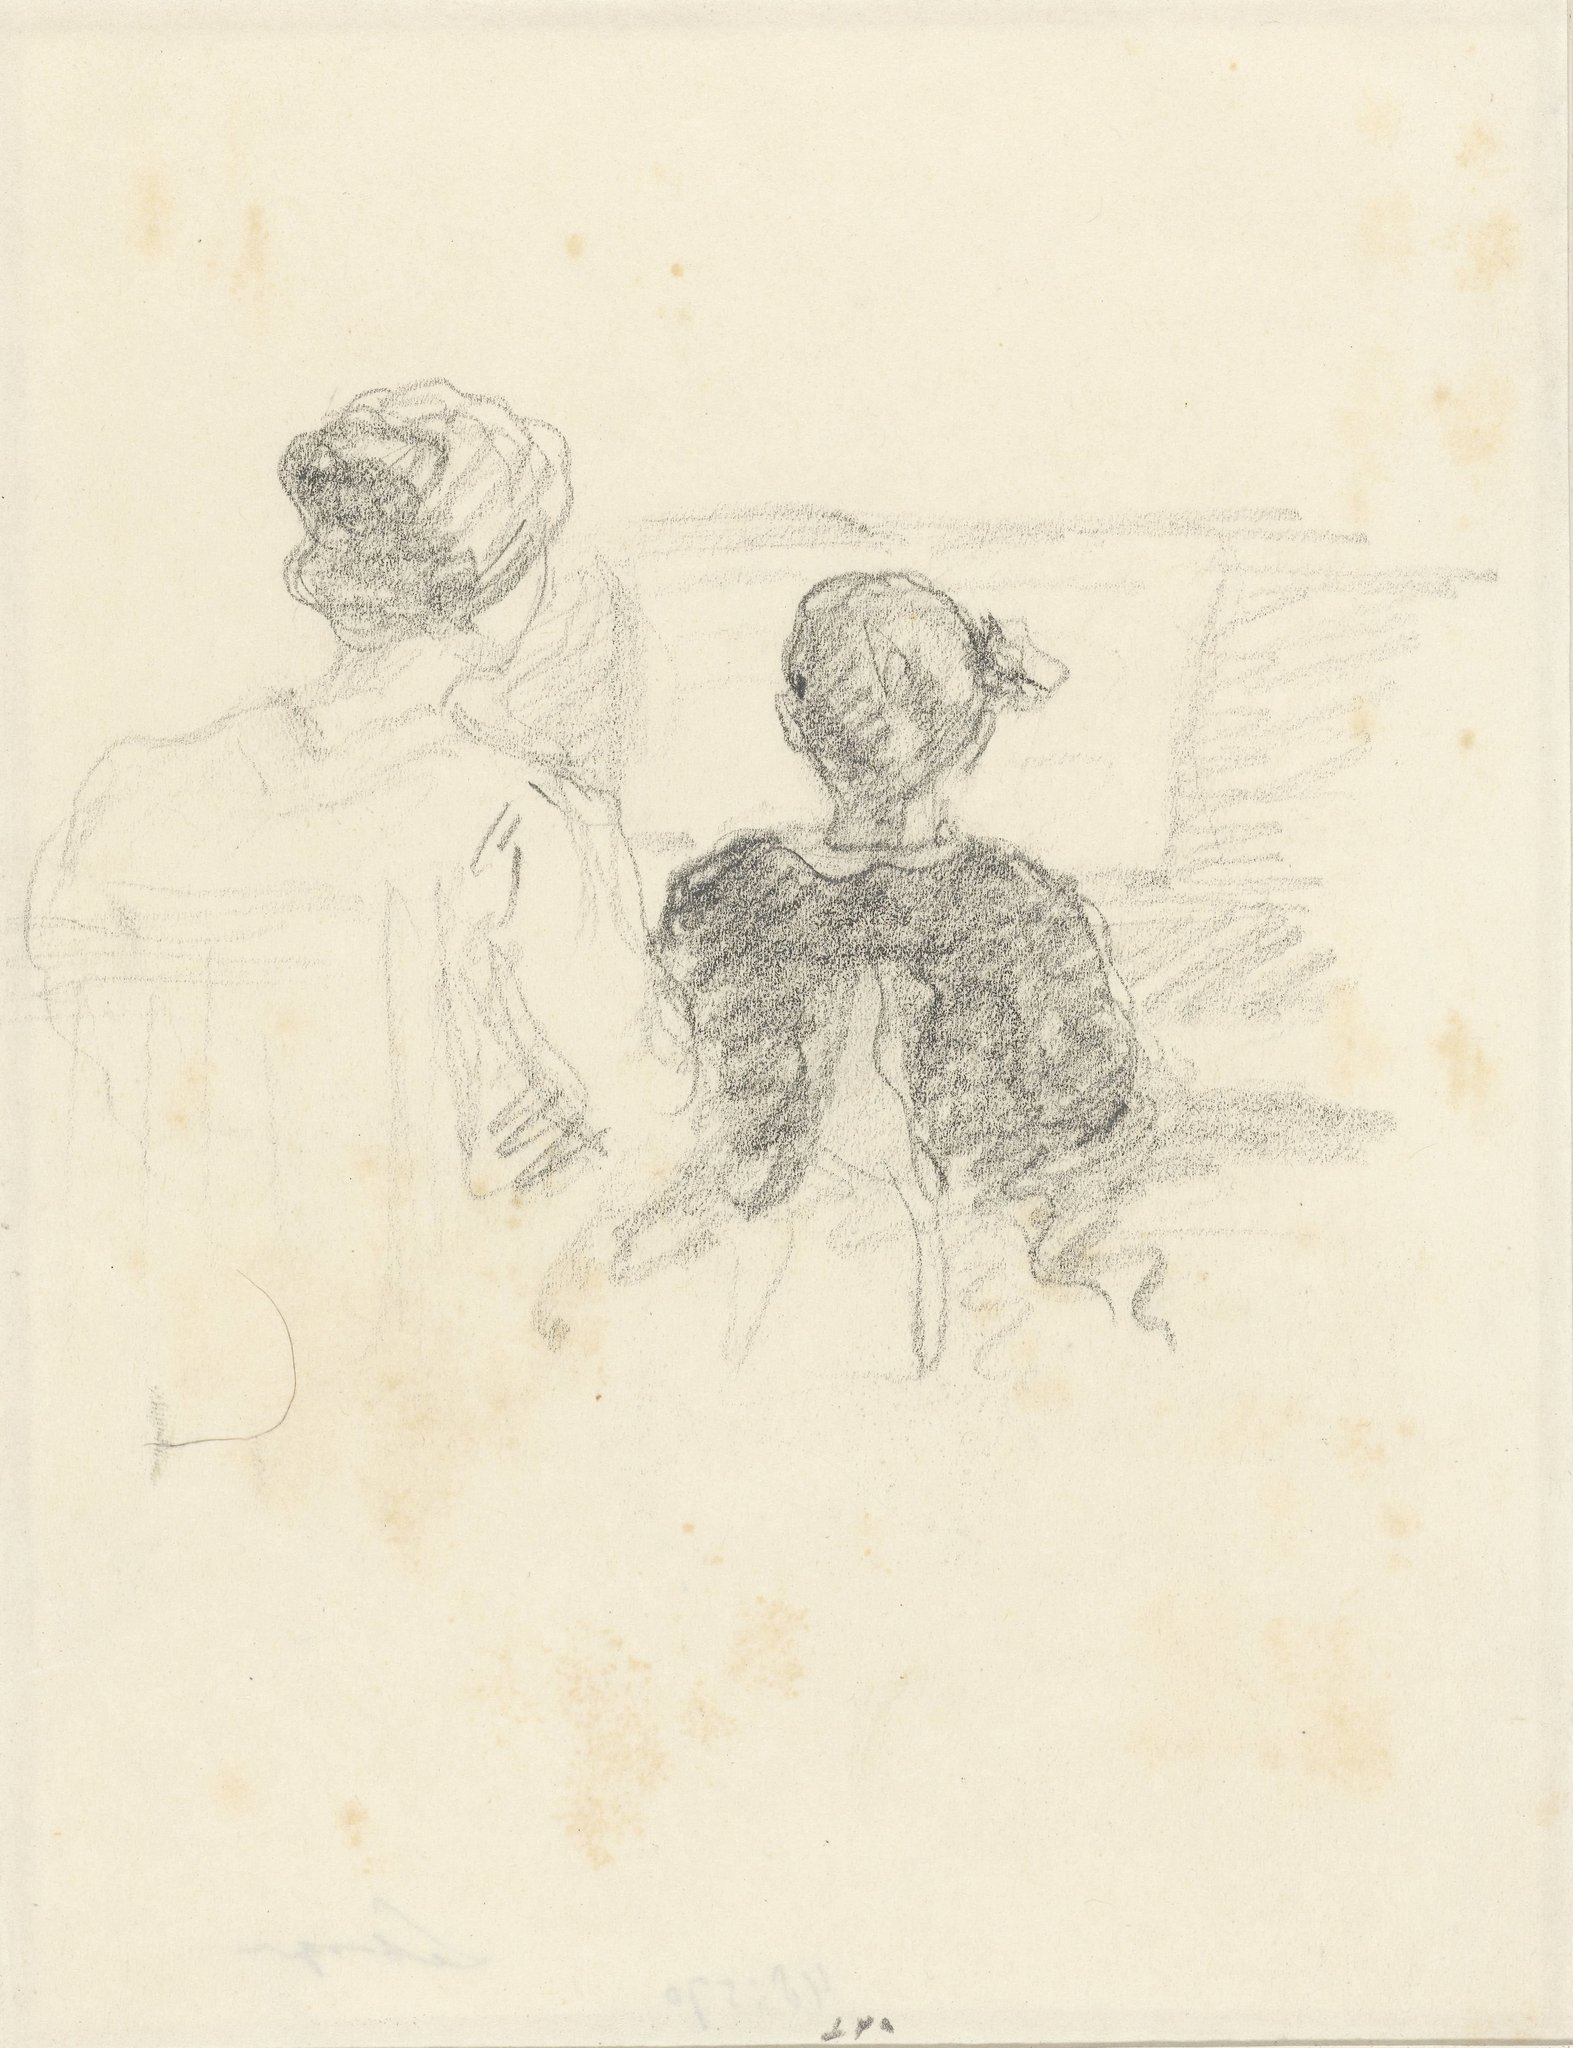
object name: drawing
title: Mevrouw Lebasque en haar dochtertje voor de piano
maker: henri lebasque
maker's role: draughtsman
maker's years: 1865-1937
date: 1885-1937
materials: paper, pencil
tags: one person playing keyboard instrument, clavichord, harpsichord